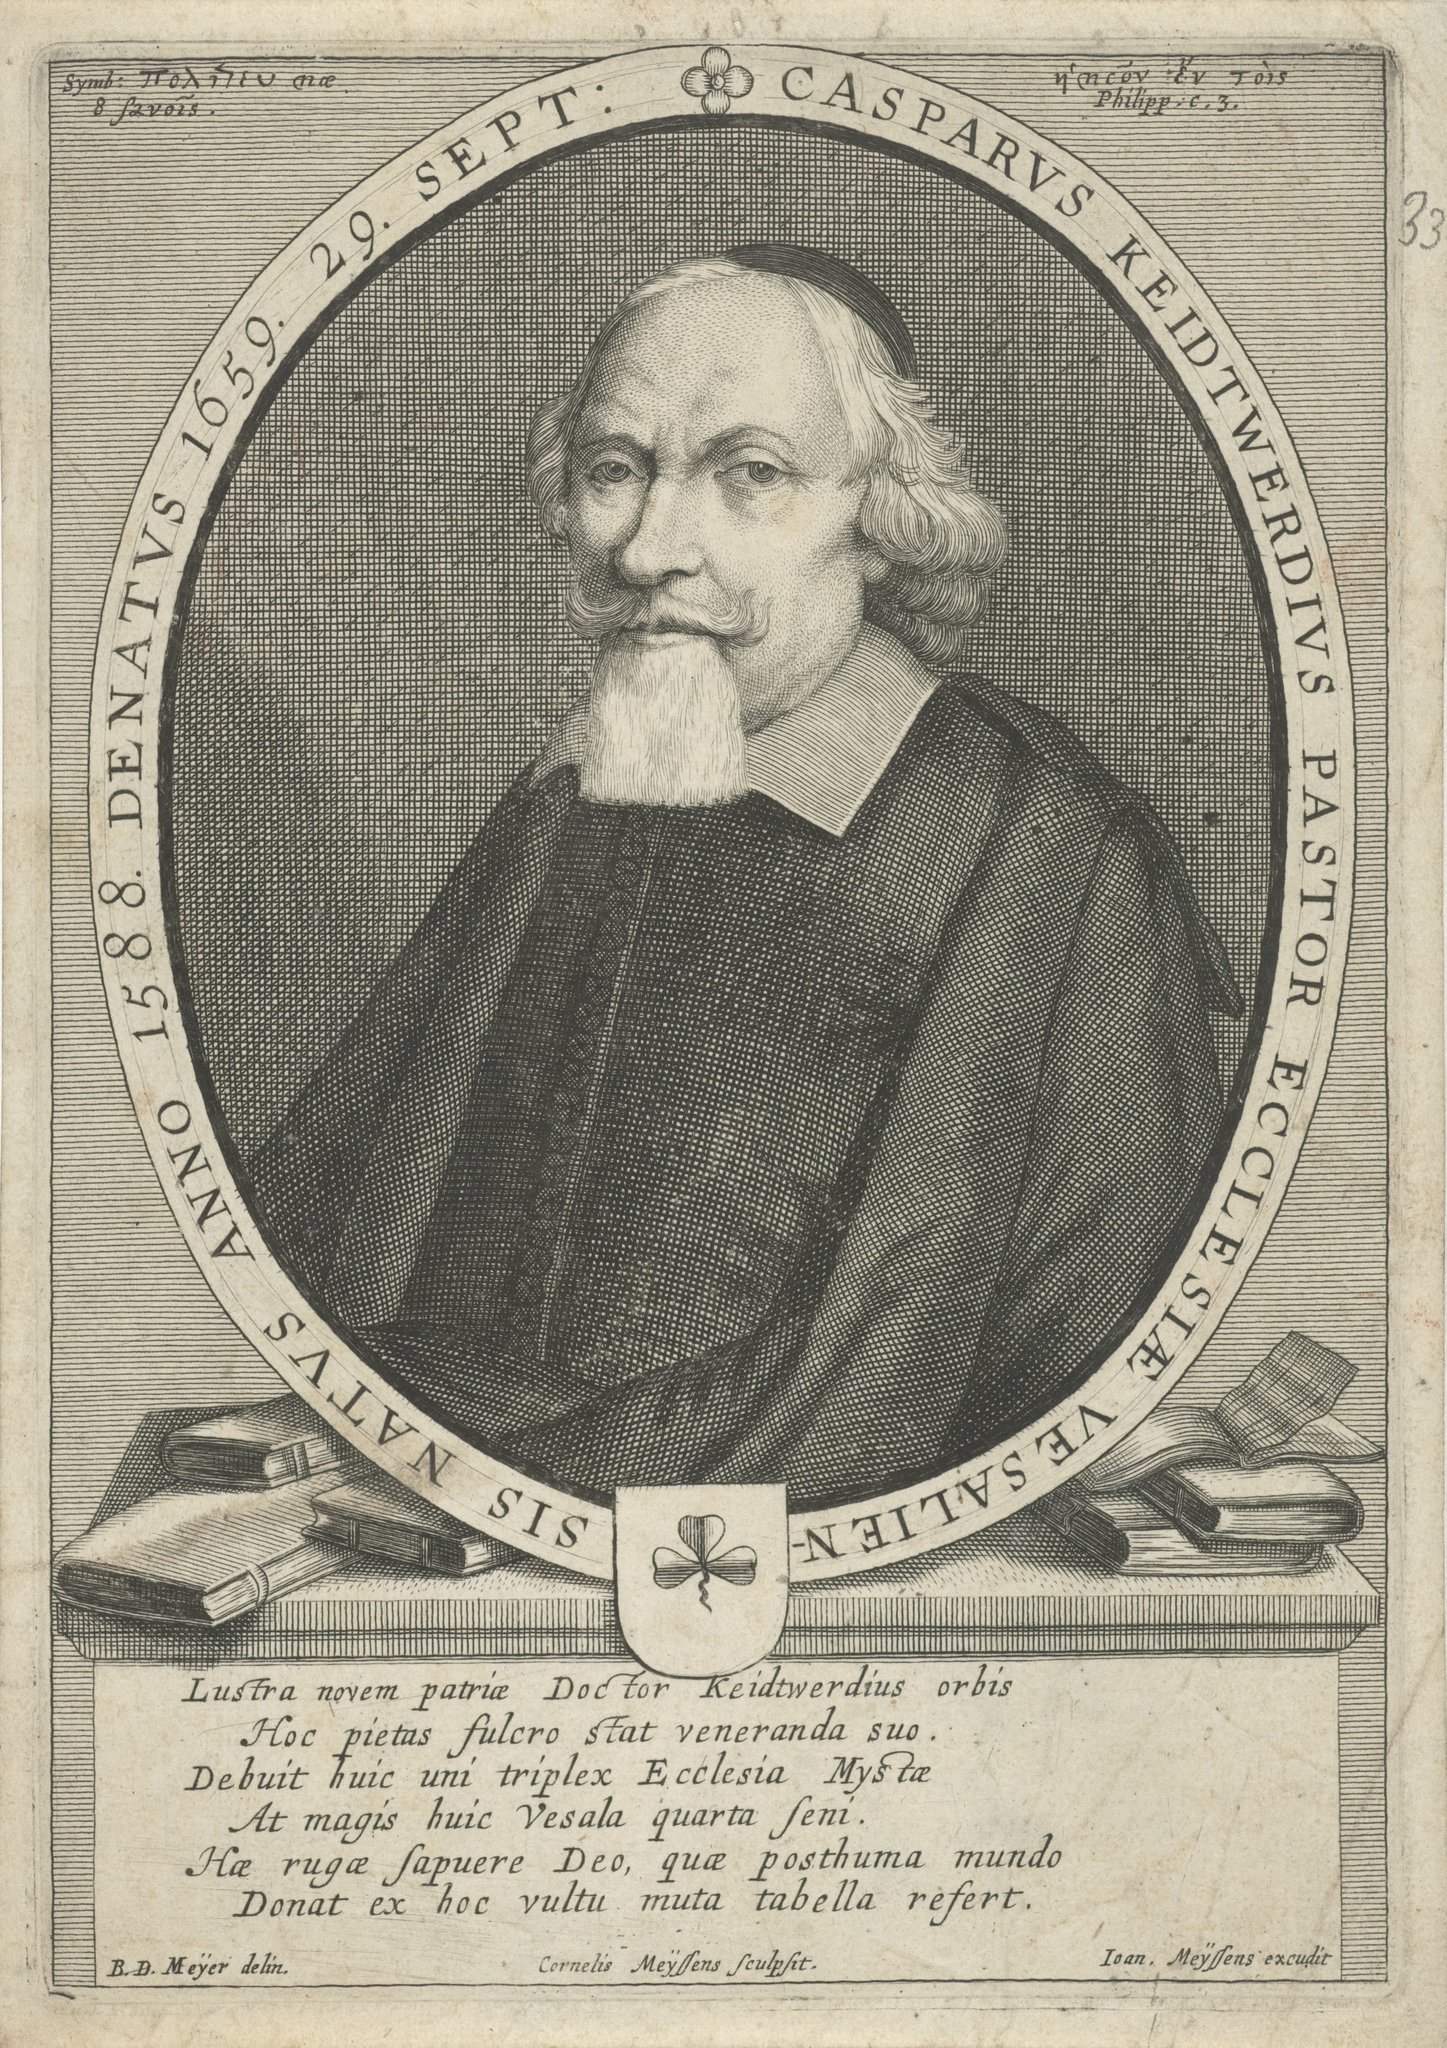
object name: print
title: Portret van Casparus Keidtwerdius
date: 1650-1670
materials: paper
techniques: engraving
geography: antwerp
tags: predikant, casparus keidtwerdius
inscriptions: collector's mark: Lugt 2228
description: Portret van predikant Casparus Keidtwerdius in een ovale lijst met randschrift. Onder het portret liggen boeken op het basement. Onderaan een zesregelige tekst in het Latijn.